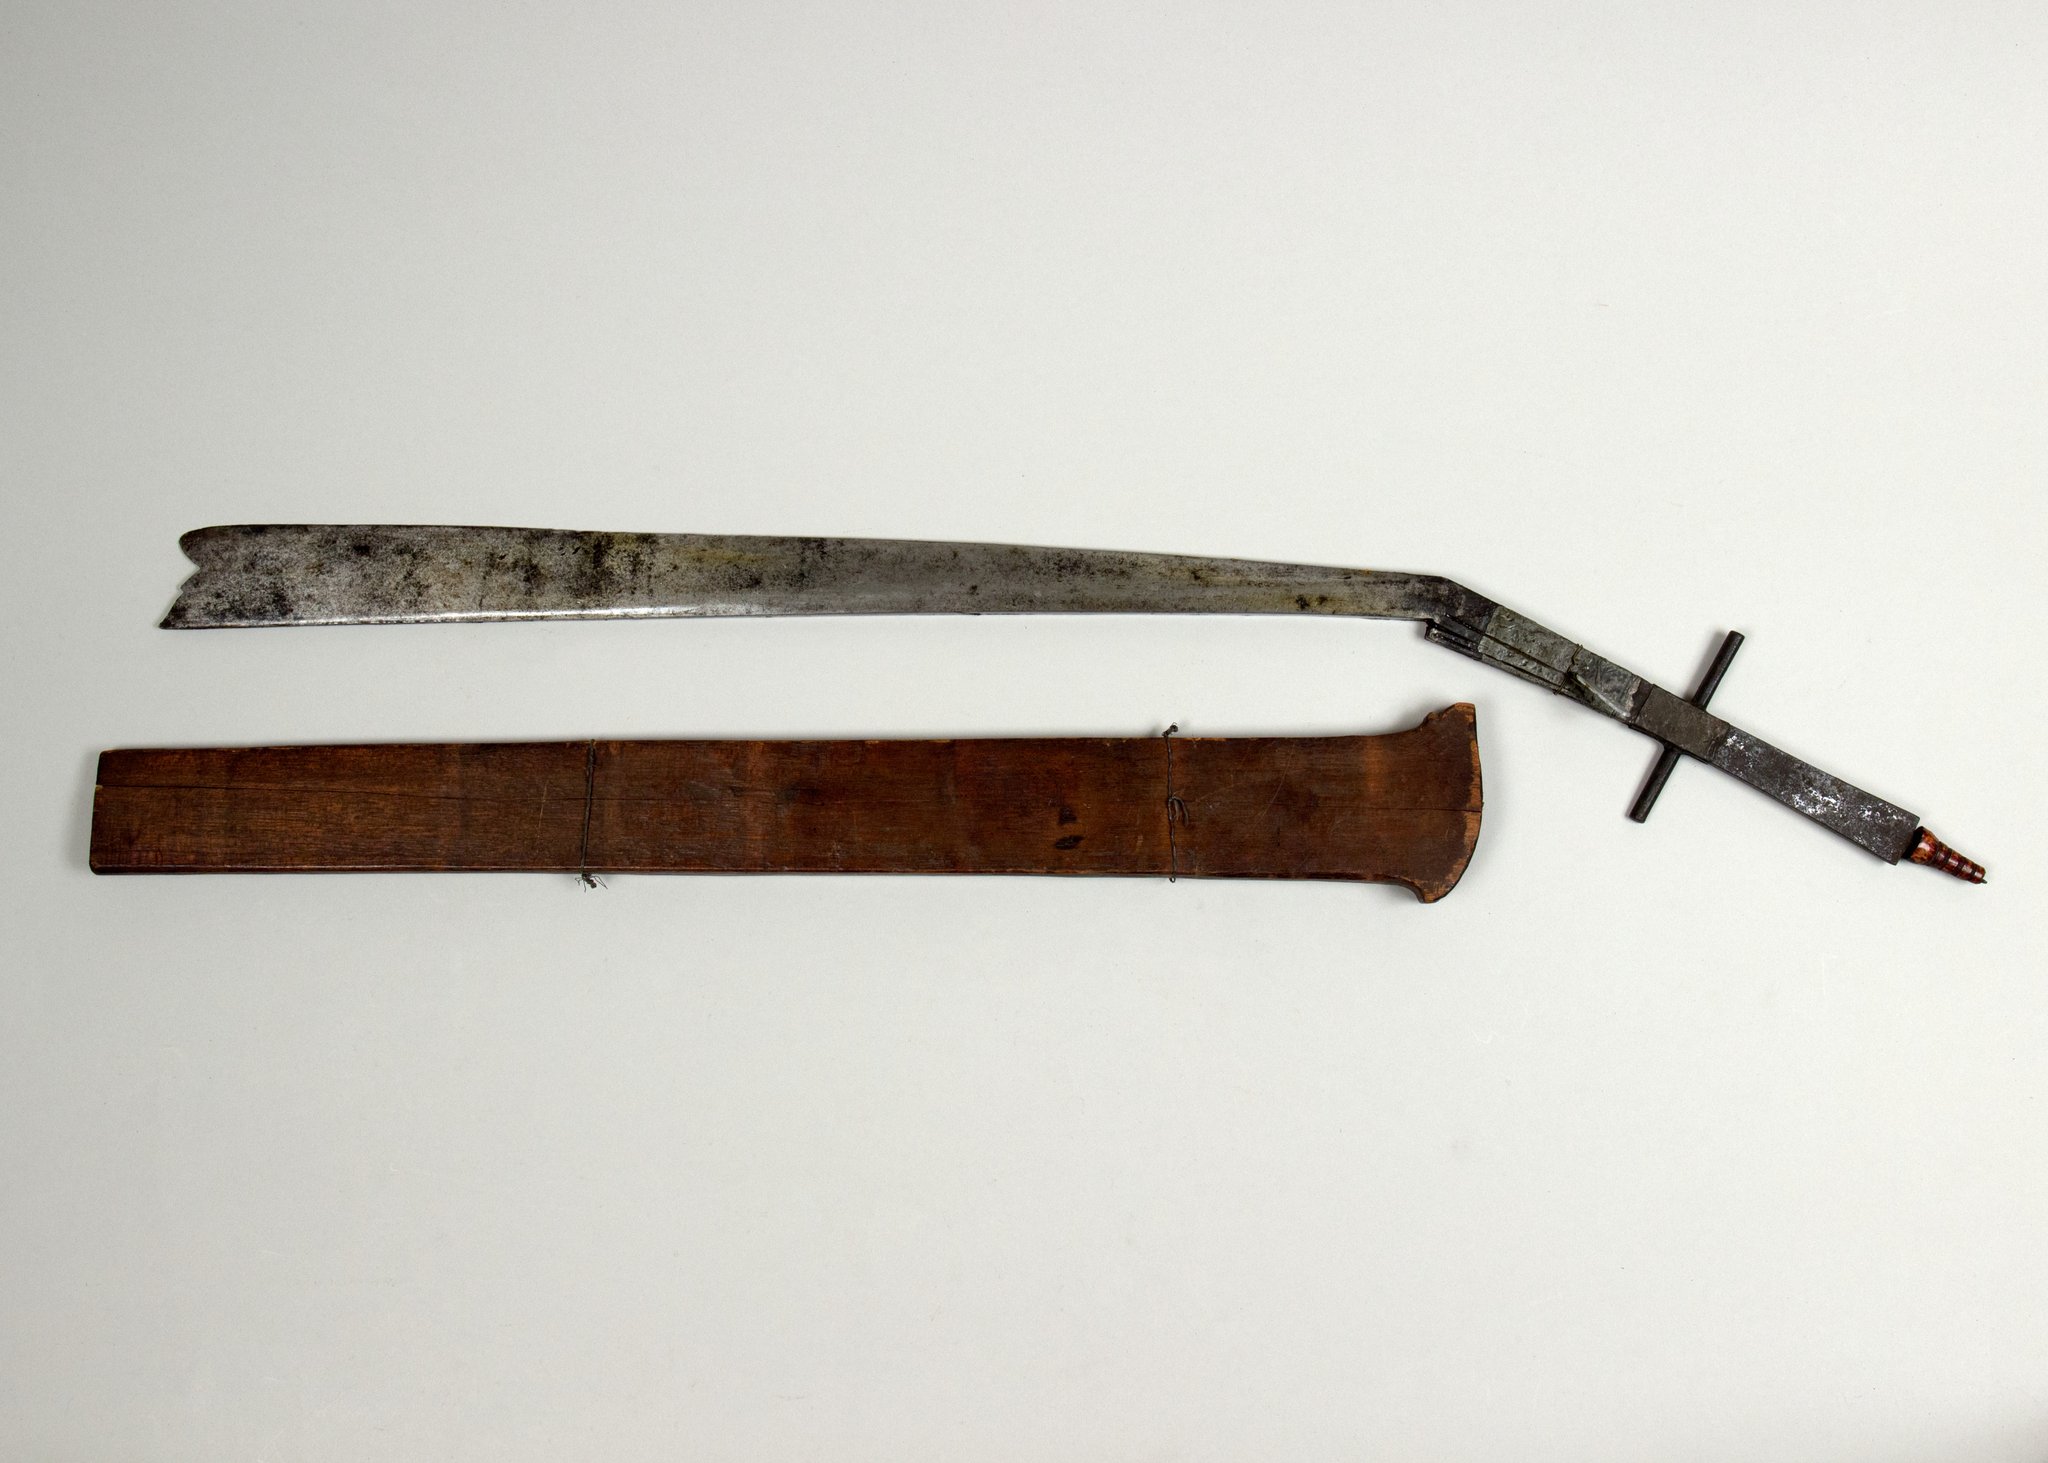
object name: sword parang pandit with scabbard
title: Sword (Parang Pandit) with Scabbard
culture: dyak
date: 1701-1900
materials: brass, silver, steel, wood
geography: borneo